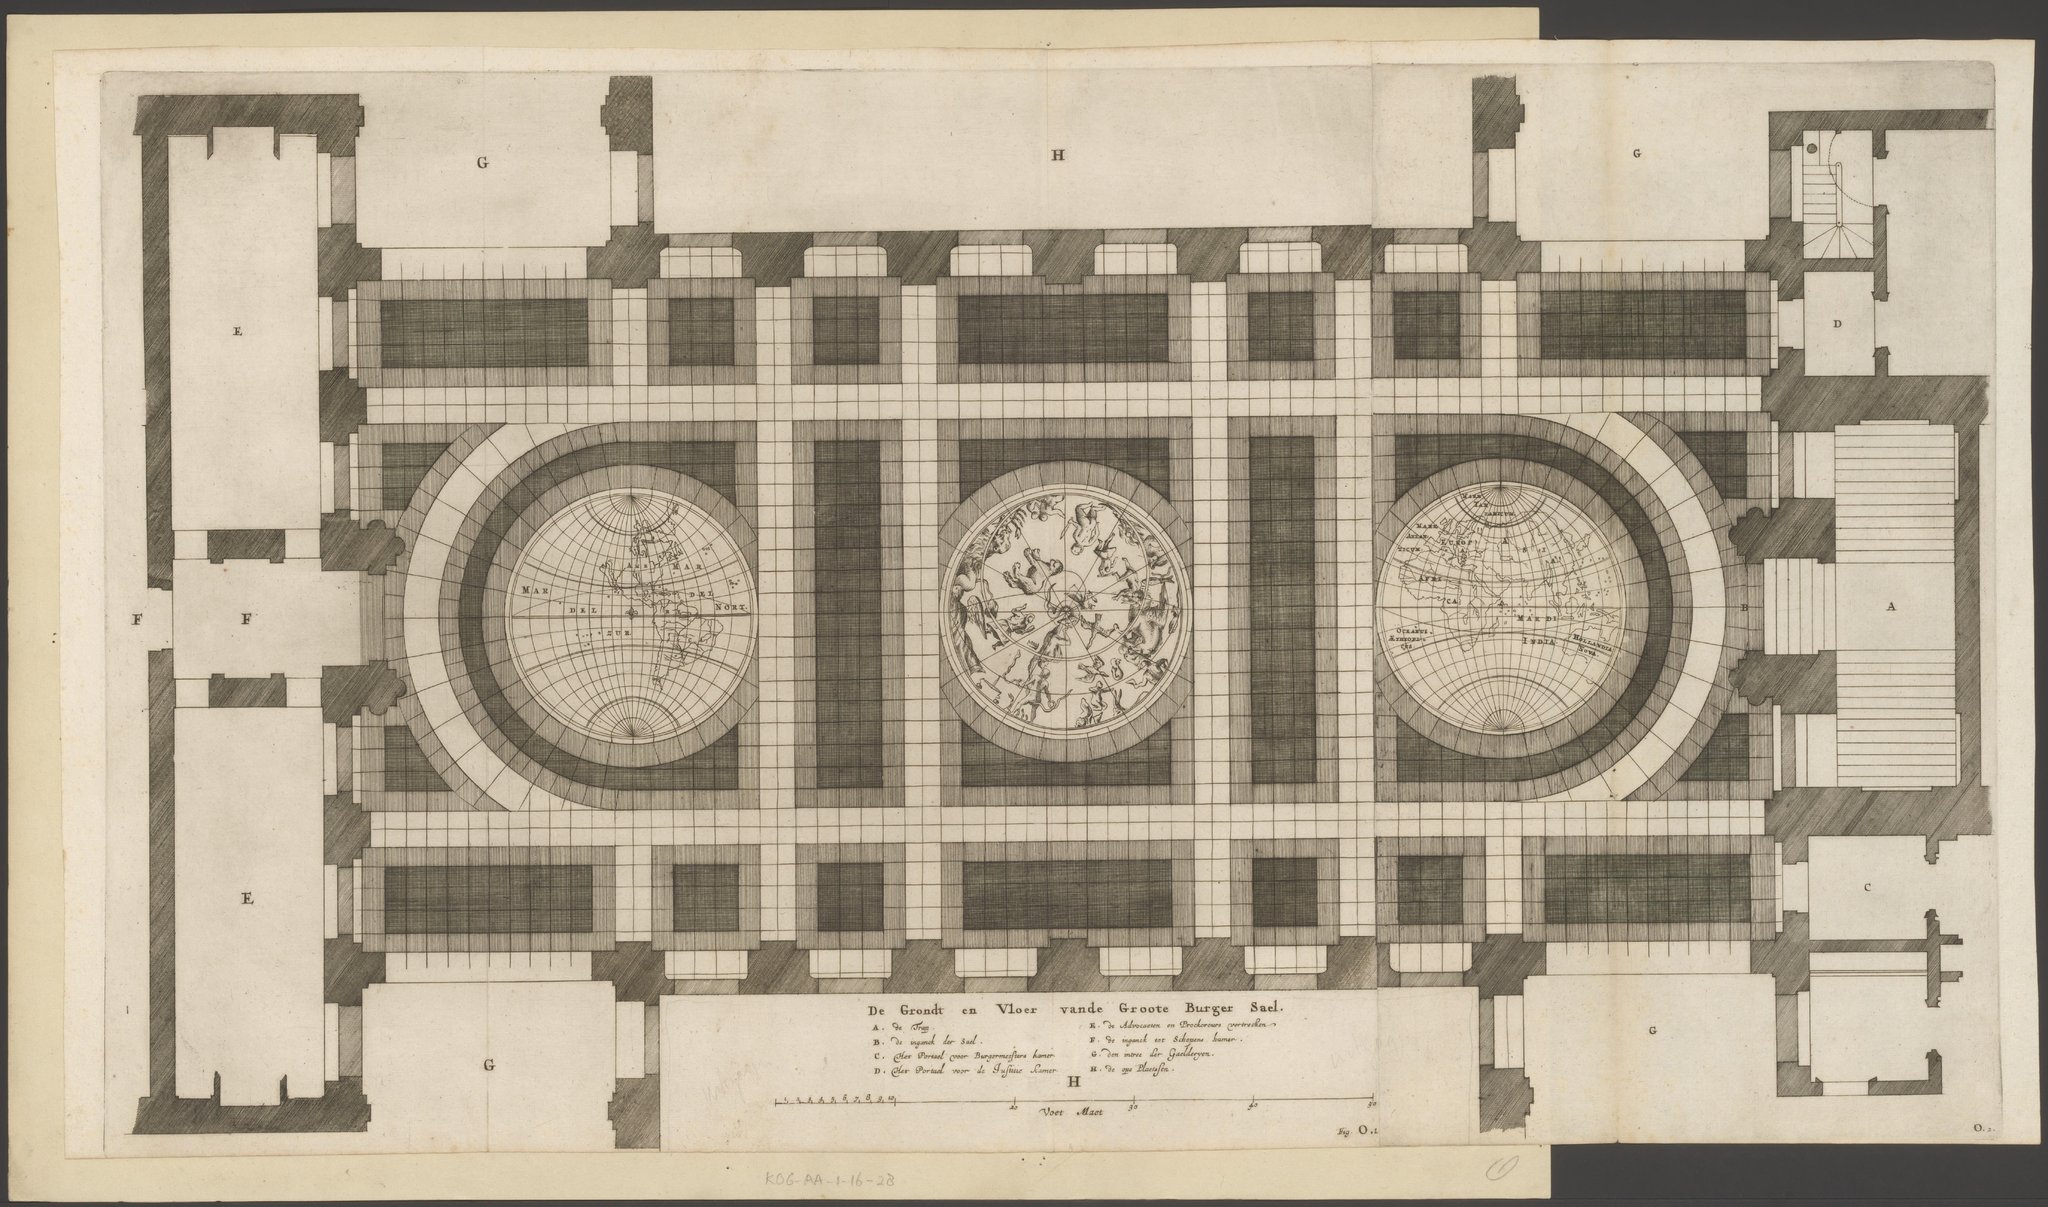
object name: print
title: De Grondt en Vloer vande Groote Burger Sael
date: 1661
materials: paper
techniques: engraving, etching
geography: amsterdam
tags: map of the world, townhall, plan ~ architecture, star-chart, star map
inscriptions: collector's mark: ‘16,28’ Lugt 1641b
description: Onderwerpsrubriek binnen de Atlas Amsterdam: Stadhuis op de Dam. Onder de schaalstok: Fig. O.1. Rechtsonder: O.2.